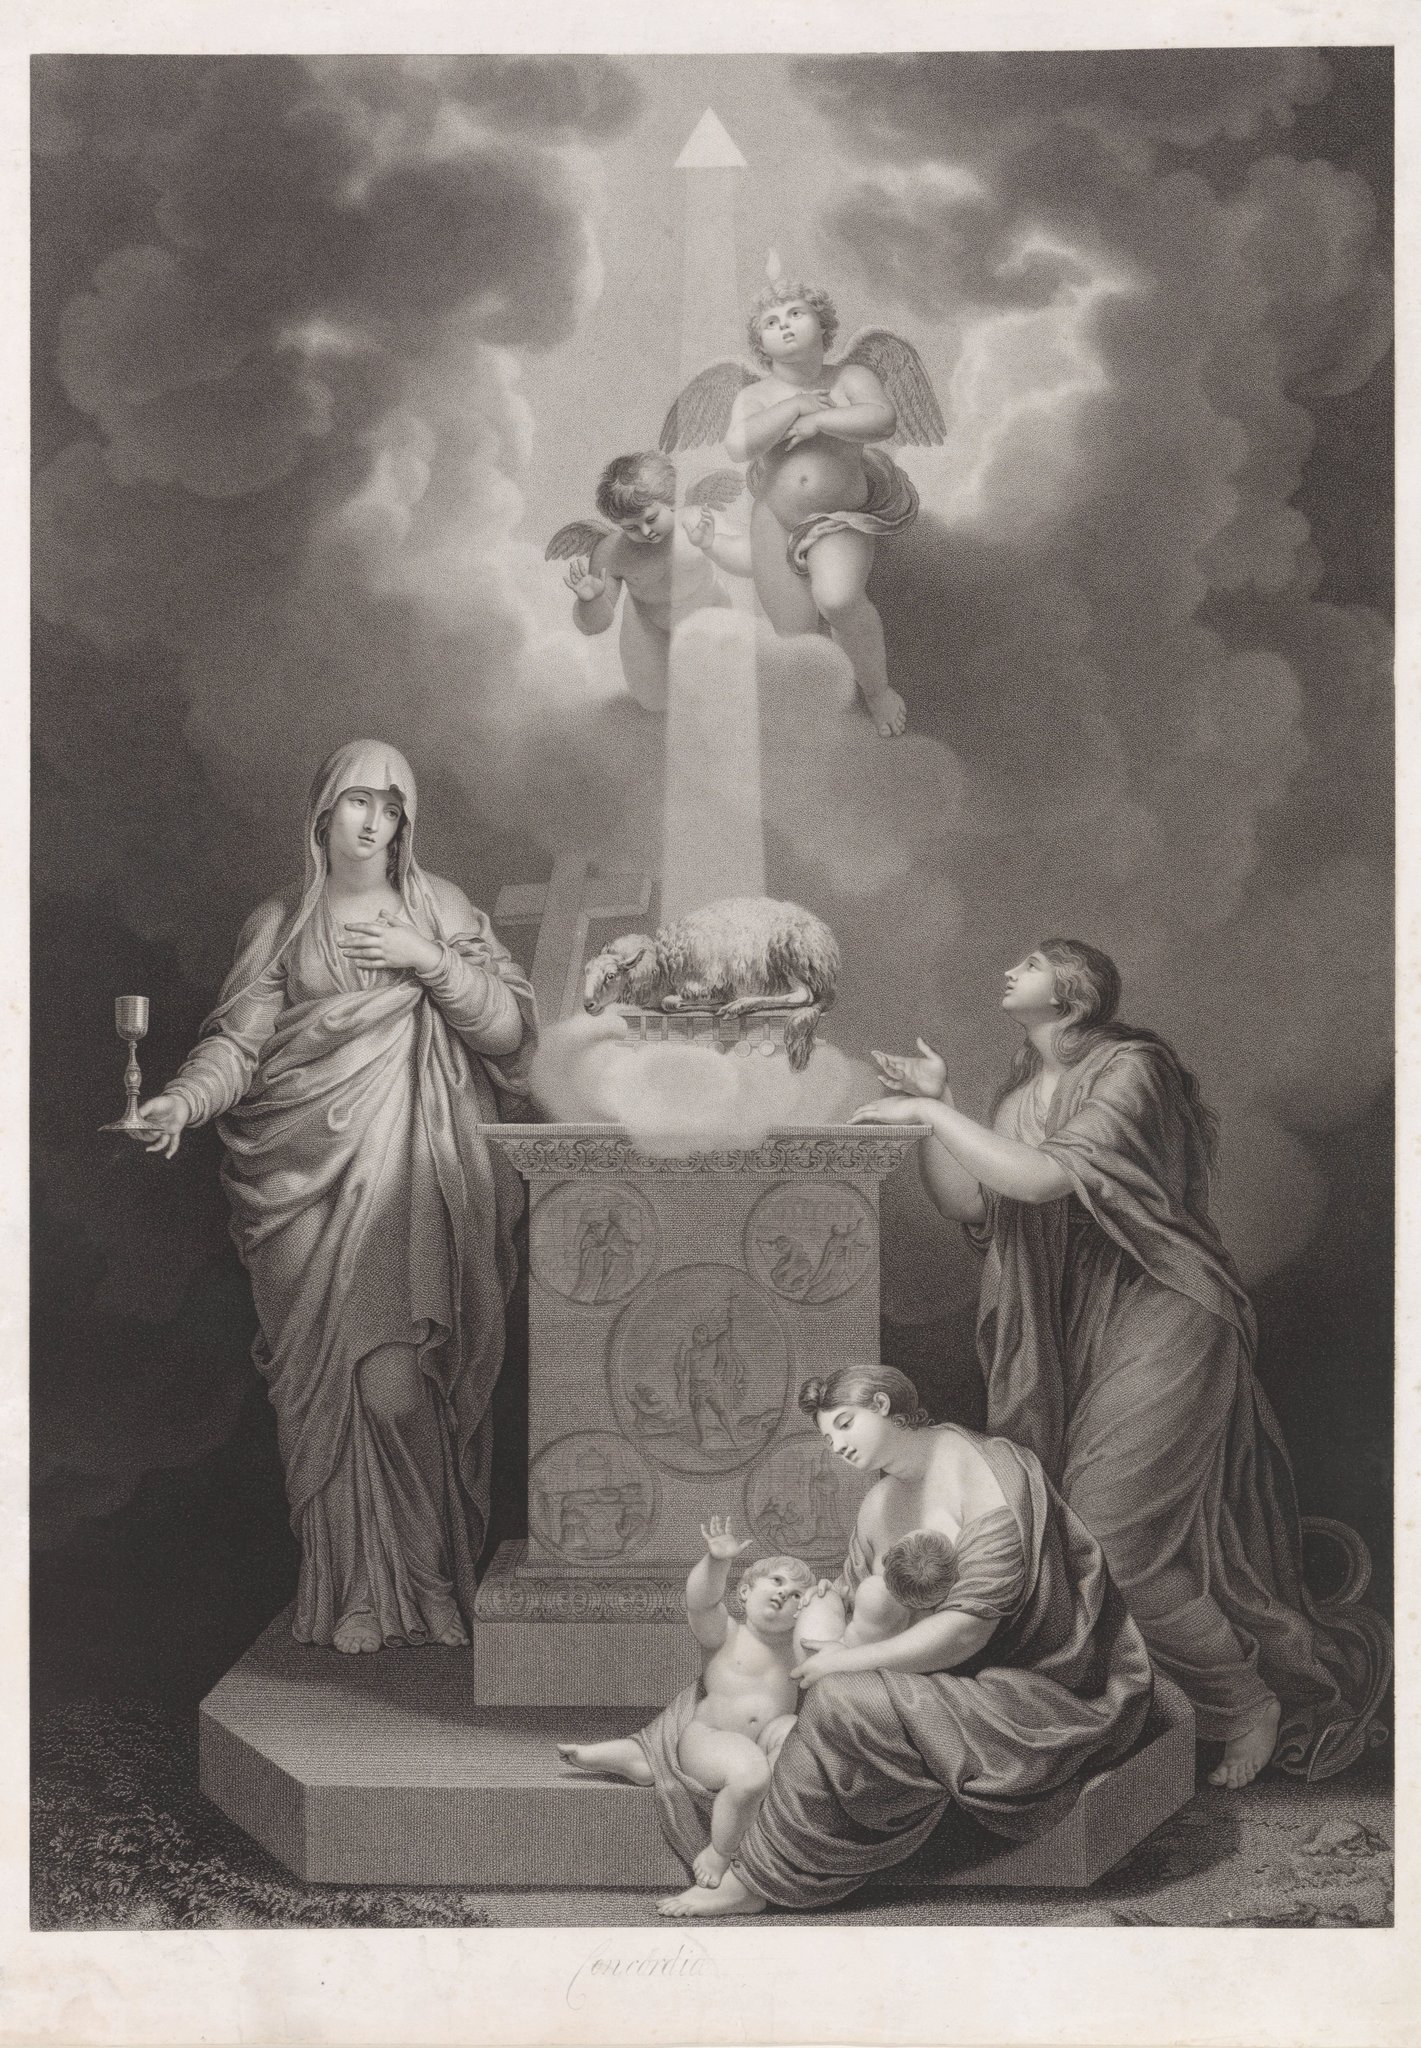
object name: print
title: Concordia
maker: Anonymous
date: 1750-1850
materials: paper, pencil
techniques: aquatint, etching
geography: low countries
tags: lamb bearing cross or banner, 'agnus dei' ~ symbol of christ (+ variant), agreement, unity; 'concordia', 'concordia insuperabile', 'concordia militare', 'concordia di pace', 'unione civile' (ripa) (+ allegorical scene, i.e. two or more personifications involved in an action), the three theological virtues, the vision of the lamb and the book with the seven seals, the all-seeing eye, triangle with eye ~ symbol of god the father (+ variant)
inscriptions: collector's mark: Lugt 2228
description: Allegorische voorstelling van Concordia: het nieuwe verbond van God met de mensheid. Aan de hemel een driehoek, symbool van God de Vader, waaruit een lichtbundel komt, die op het Lam Gods schijnt. Het Lam Gods, symbool voor Christus, ligt op het boek met de zeven zegels op een altaar. Bij het altaar staan Geloof met miskelk en kruis, Hoop met een anker en Liefde met twee kinderen. Op de wolken twee putti.